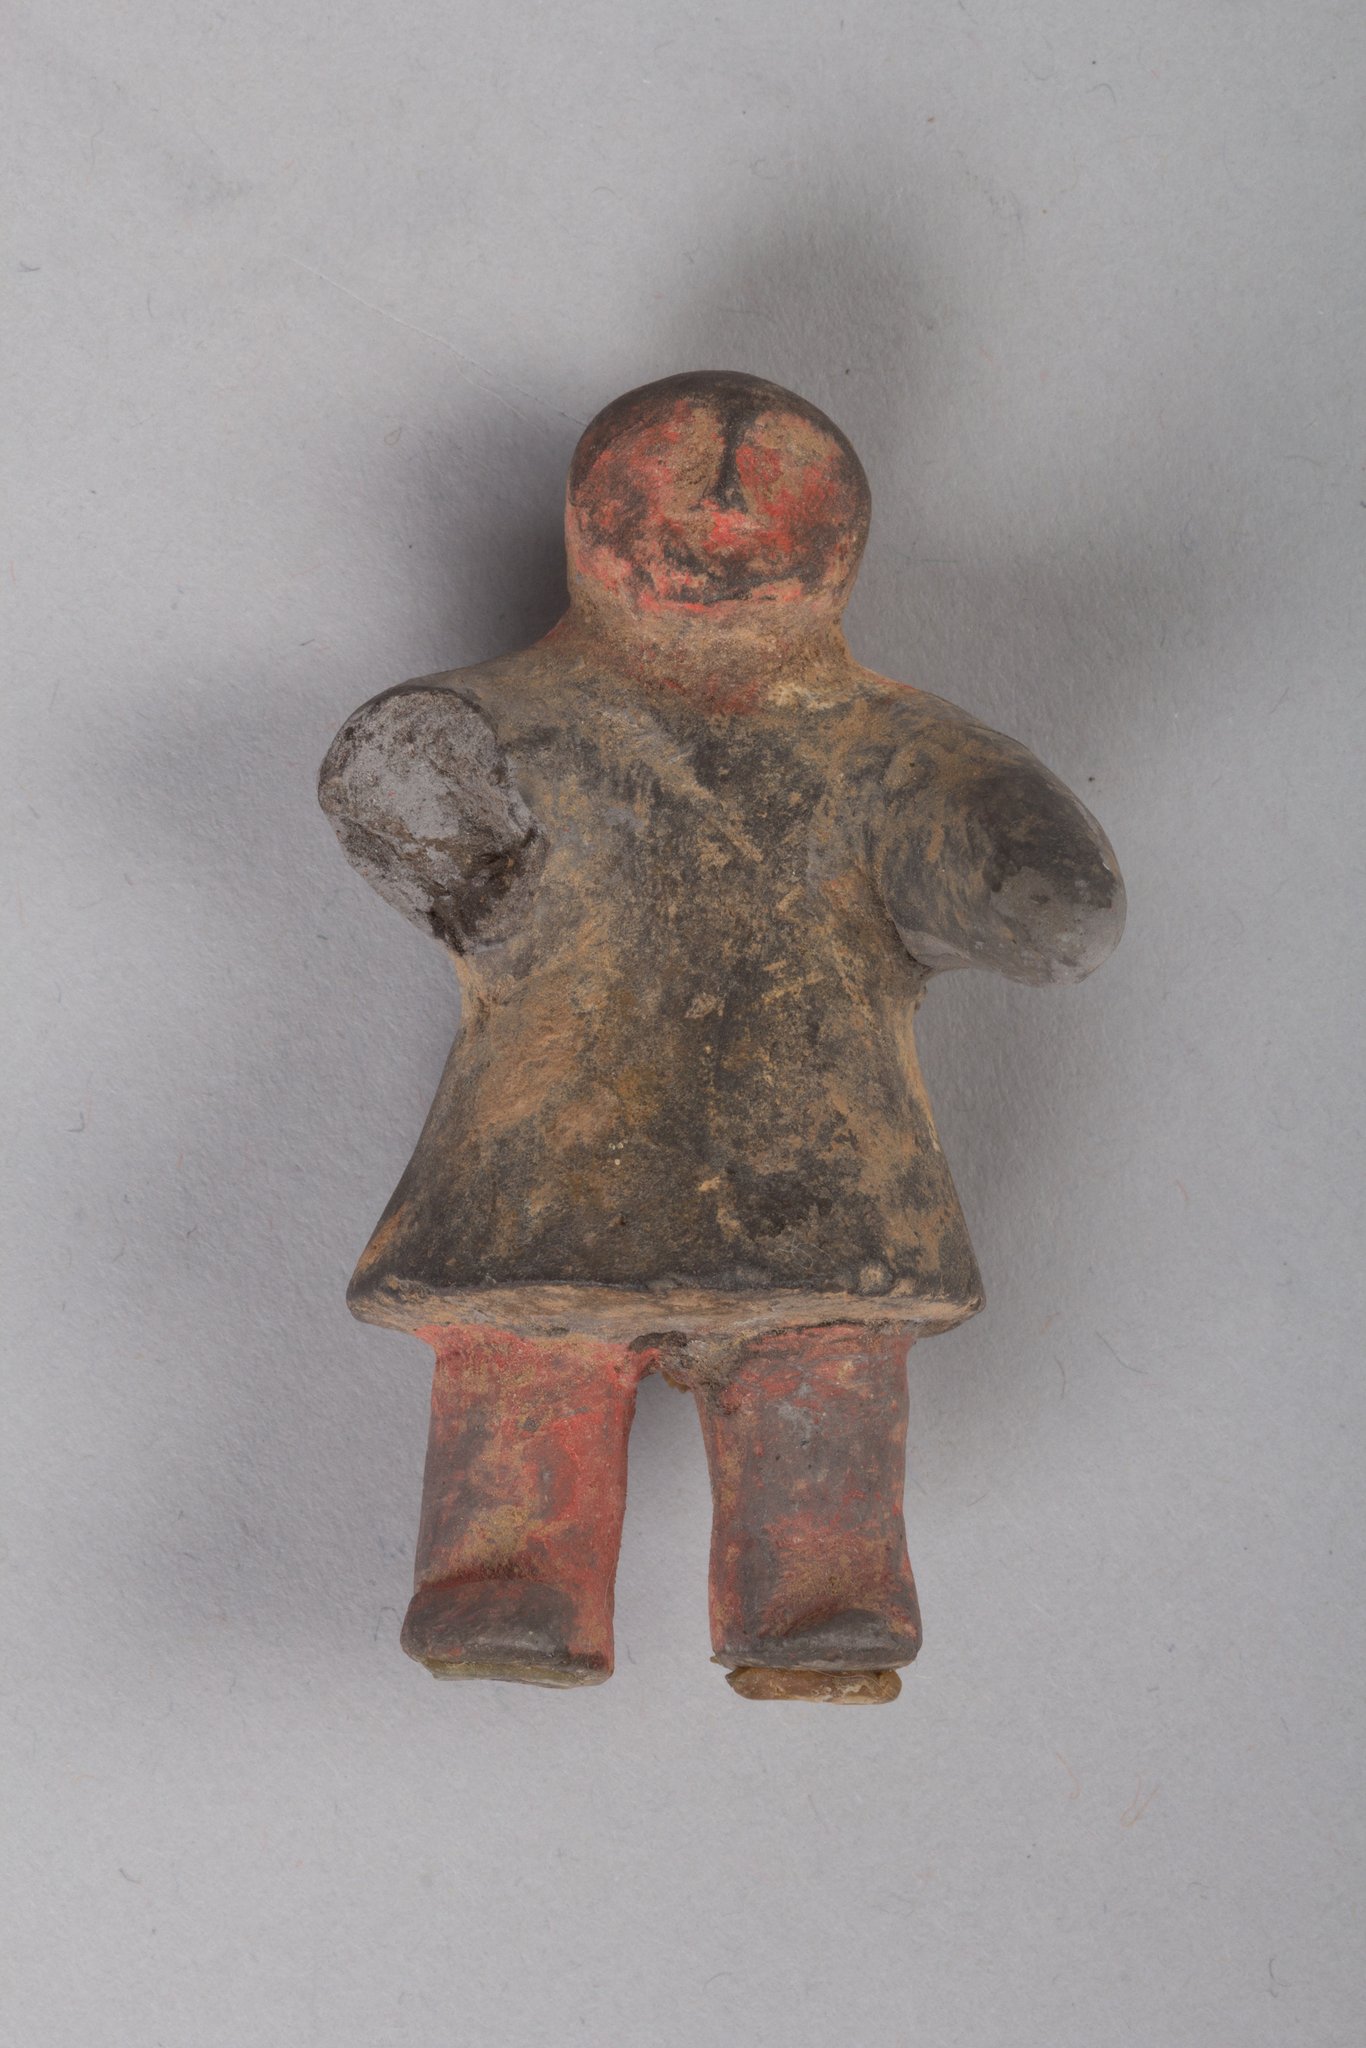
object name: figure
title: Figure of a child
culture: chinese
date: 770-256 BCE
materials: clay